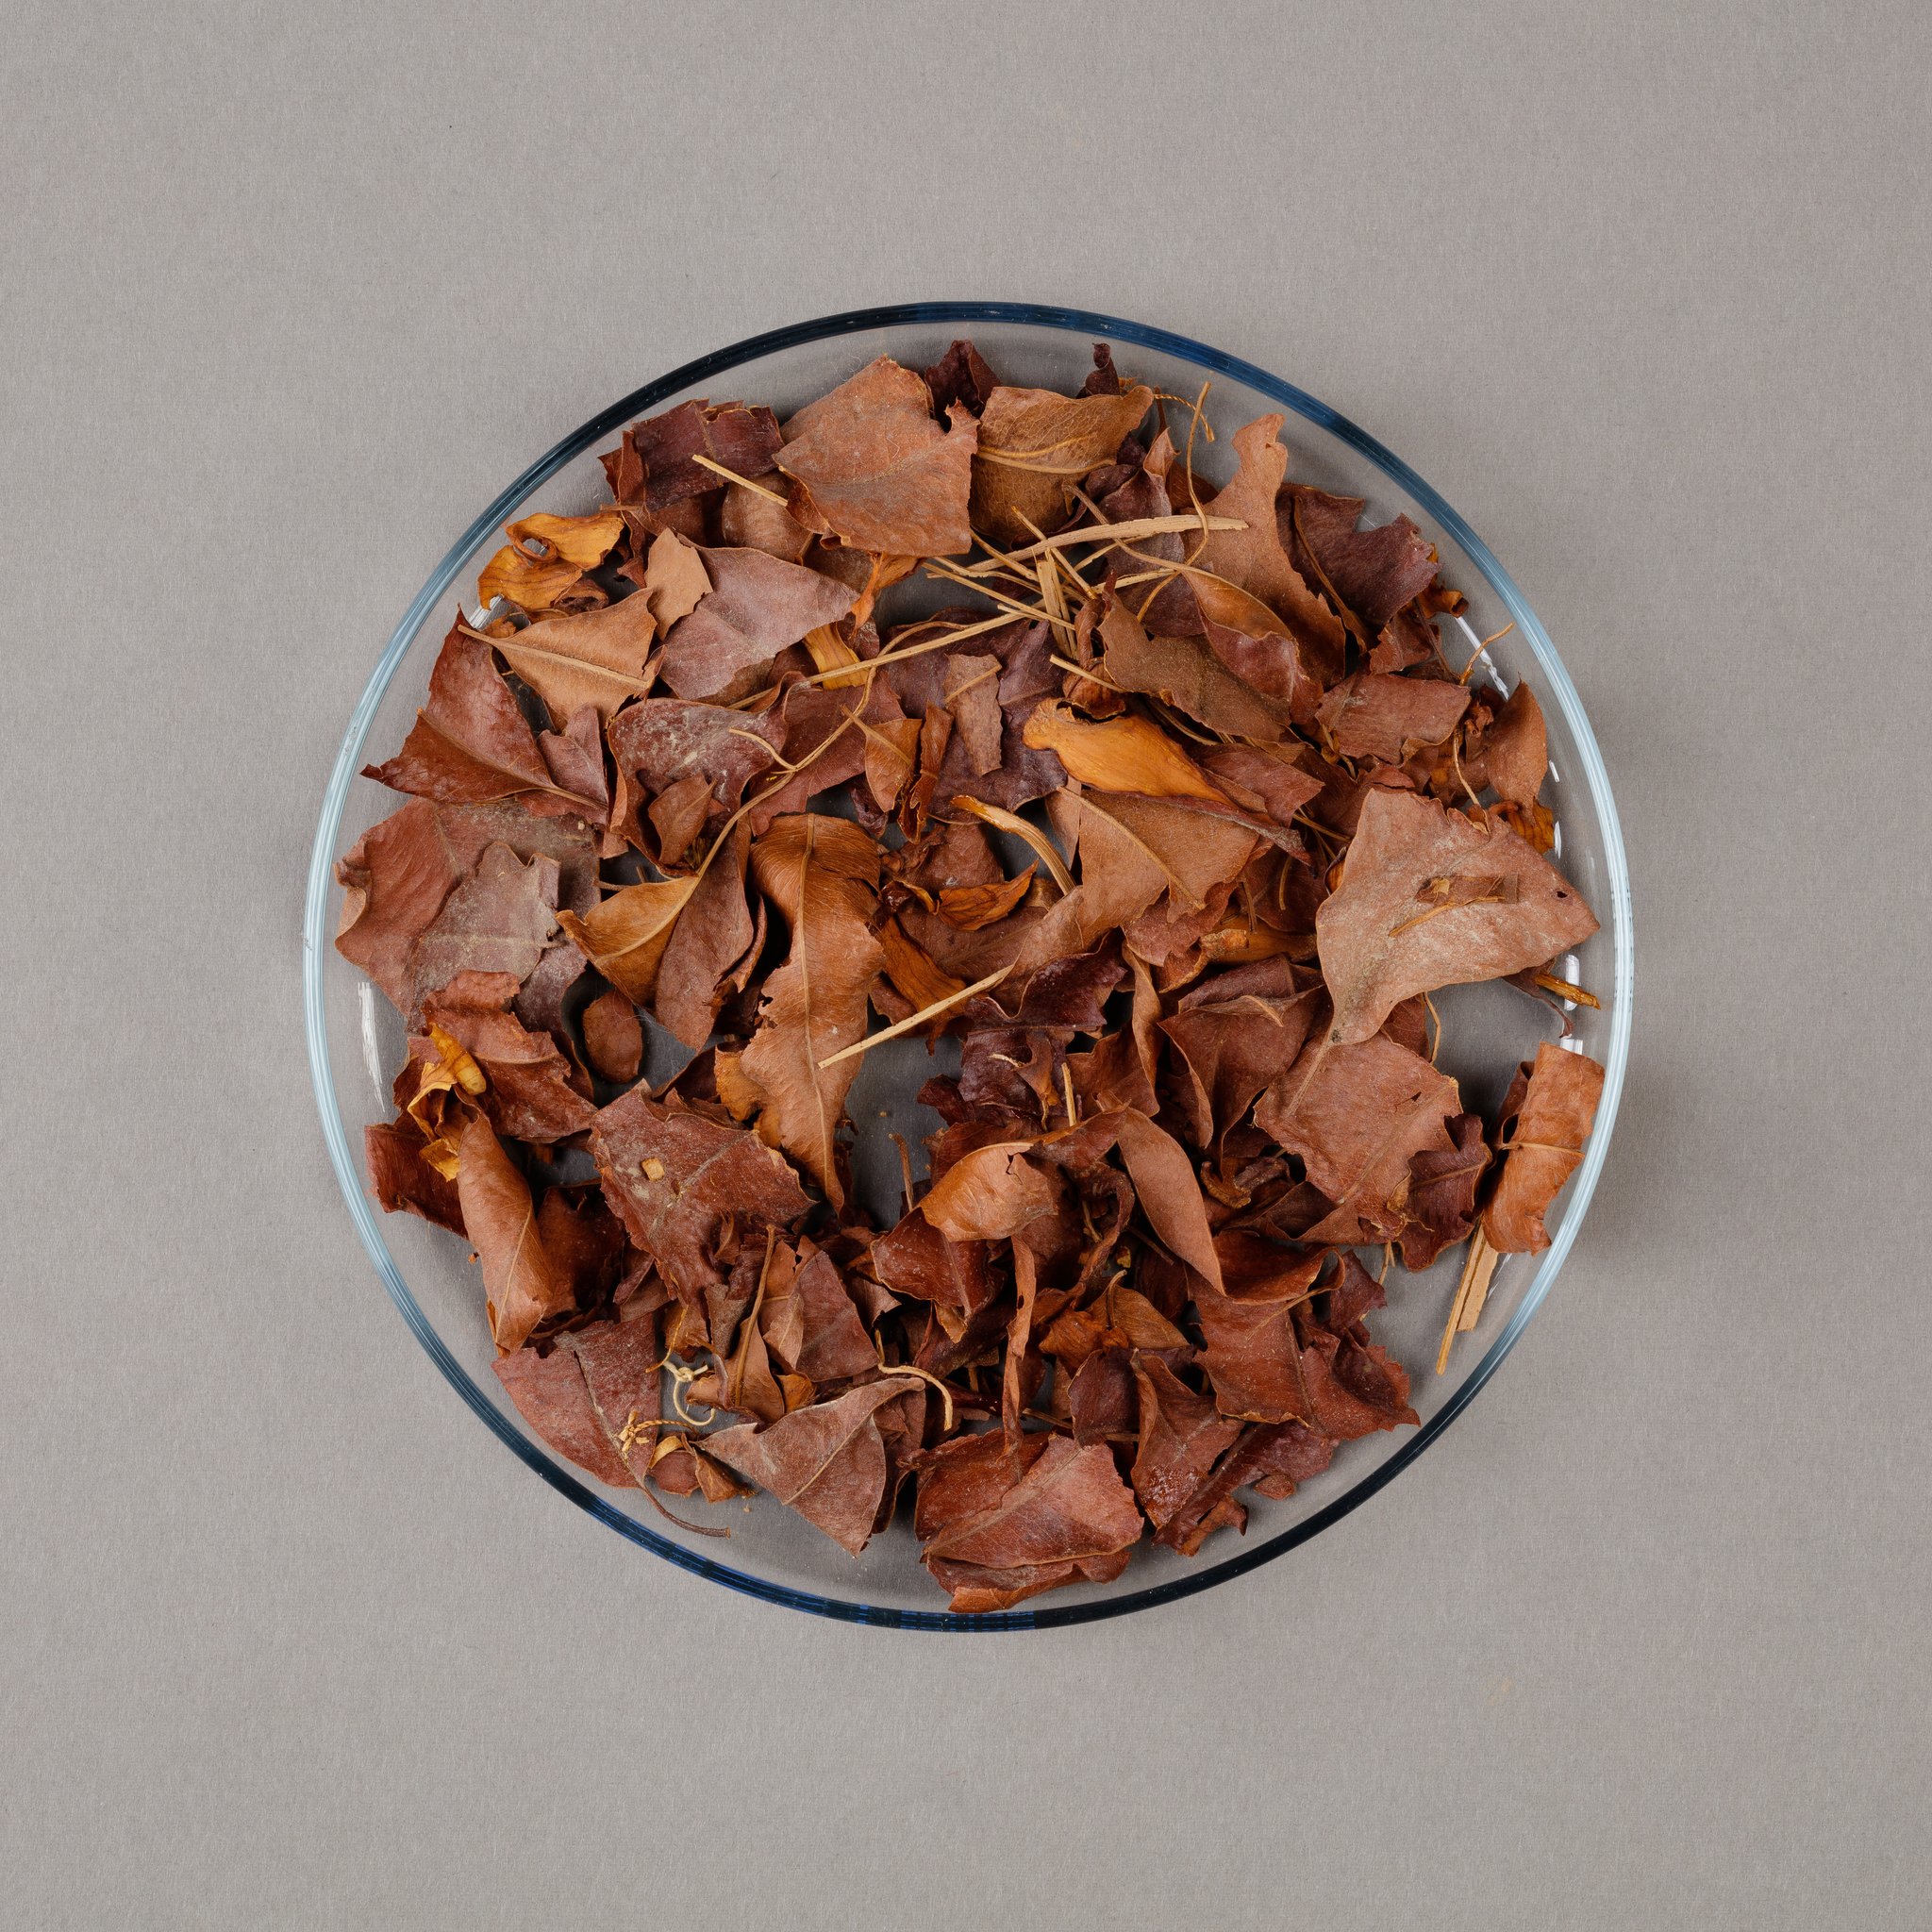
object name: garland, nauny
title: Floral Garland Fragments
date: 1050 BCE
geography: egypt